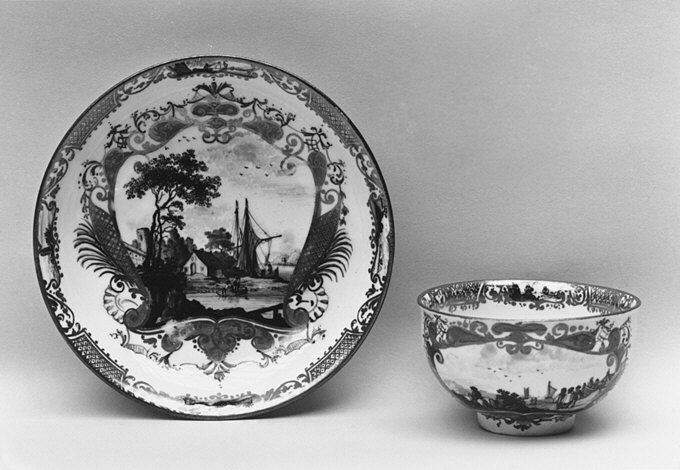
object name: saucer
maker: meissen manufactory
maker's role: manufactory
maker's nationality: german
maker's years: 1710-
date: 1735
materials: hard paste porcelain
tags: houses,landscapes,trees,ships